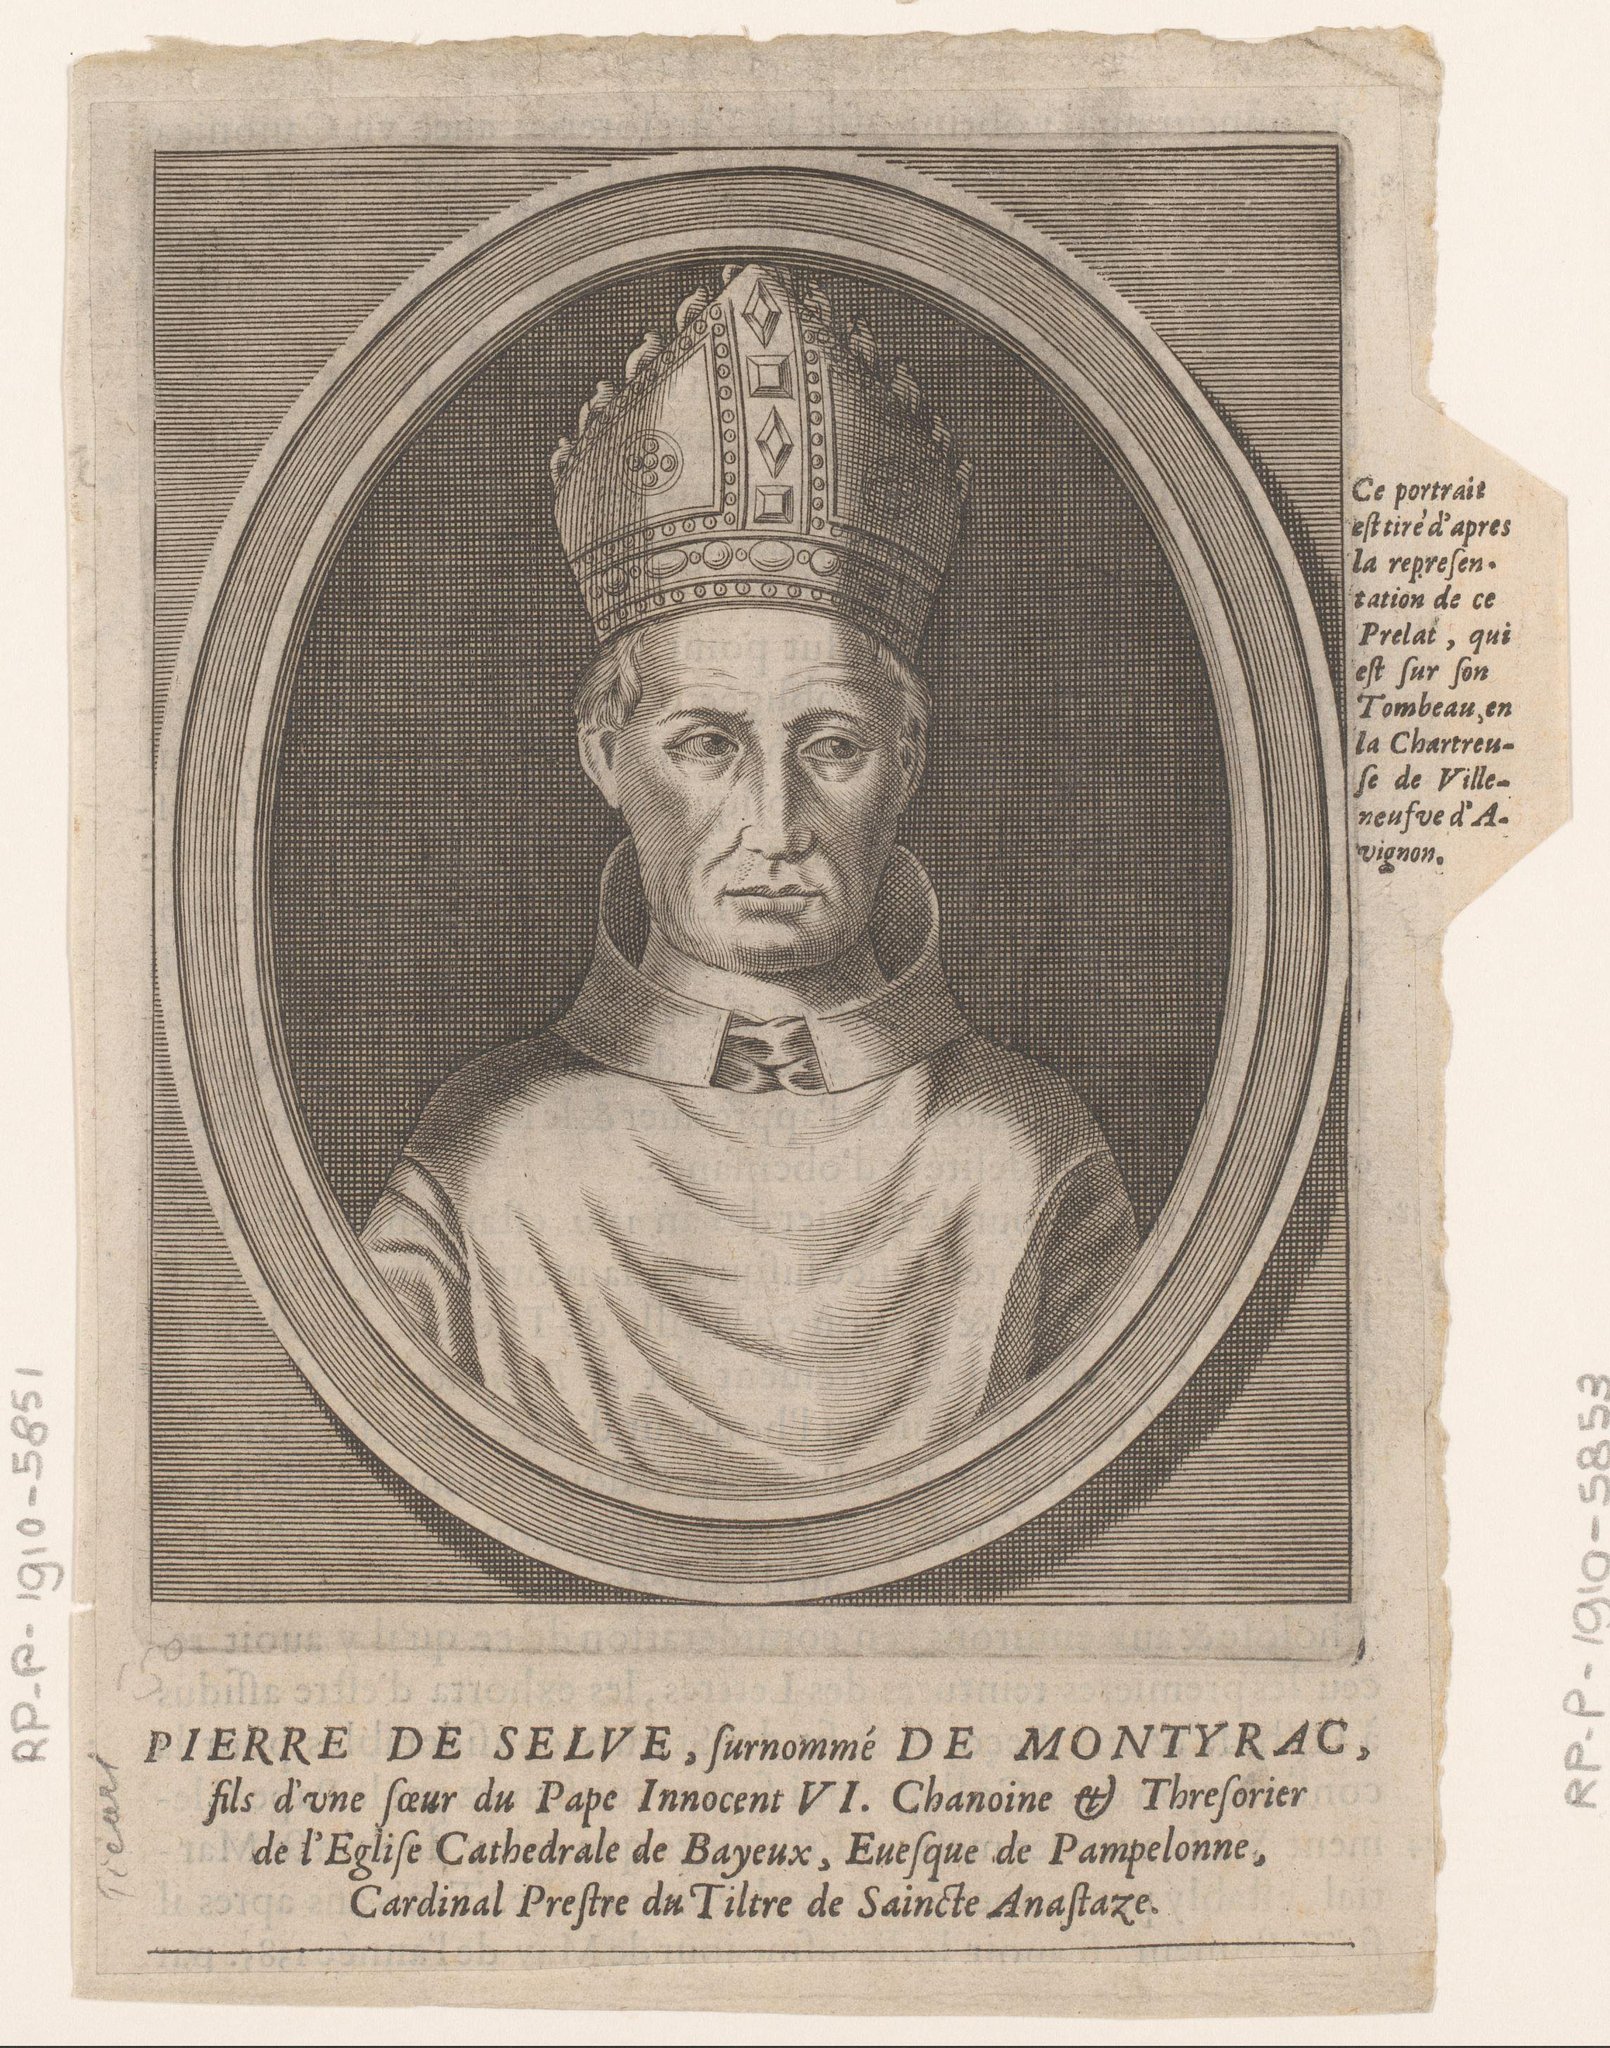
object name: print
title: Pierre de Selve, surnommé de Montyrac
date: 1660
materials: paper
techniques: engraving, etching, letterpress printing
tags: archbishop, bishop, etc. (roman catholic), cardinal, historical persons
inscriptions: collector's mark: Lugt 2228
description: Prent uit: Du Chesne, François. Histoire de tous les cardinaux françois de naissance, ou qui ont esté promeus au cardinalat. Parijs: François Du Chesne, 1660.